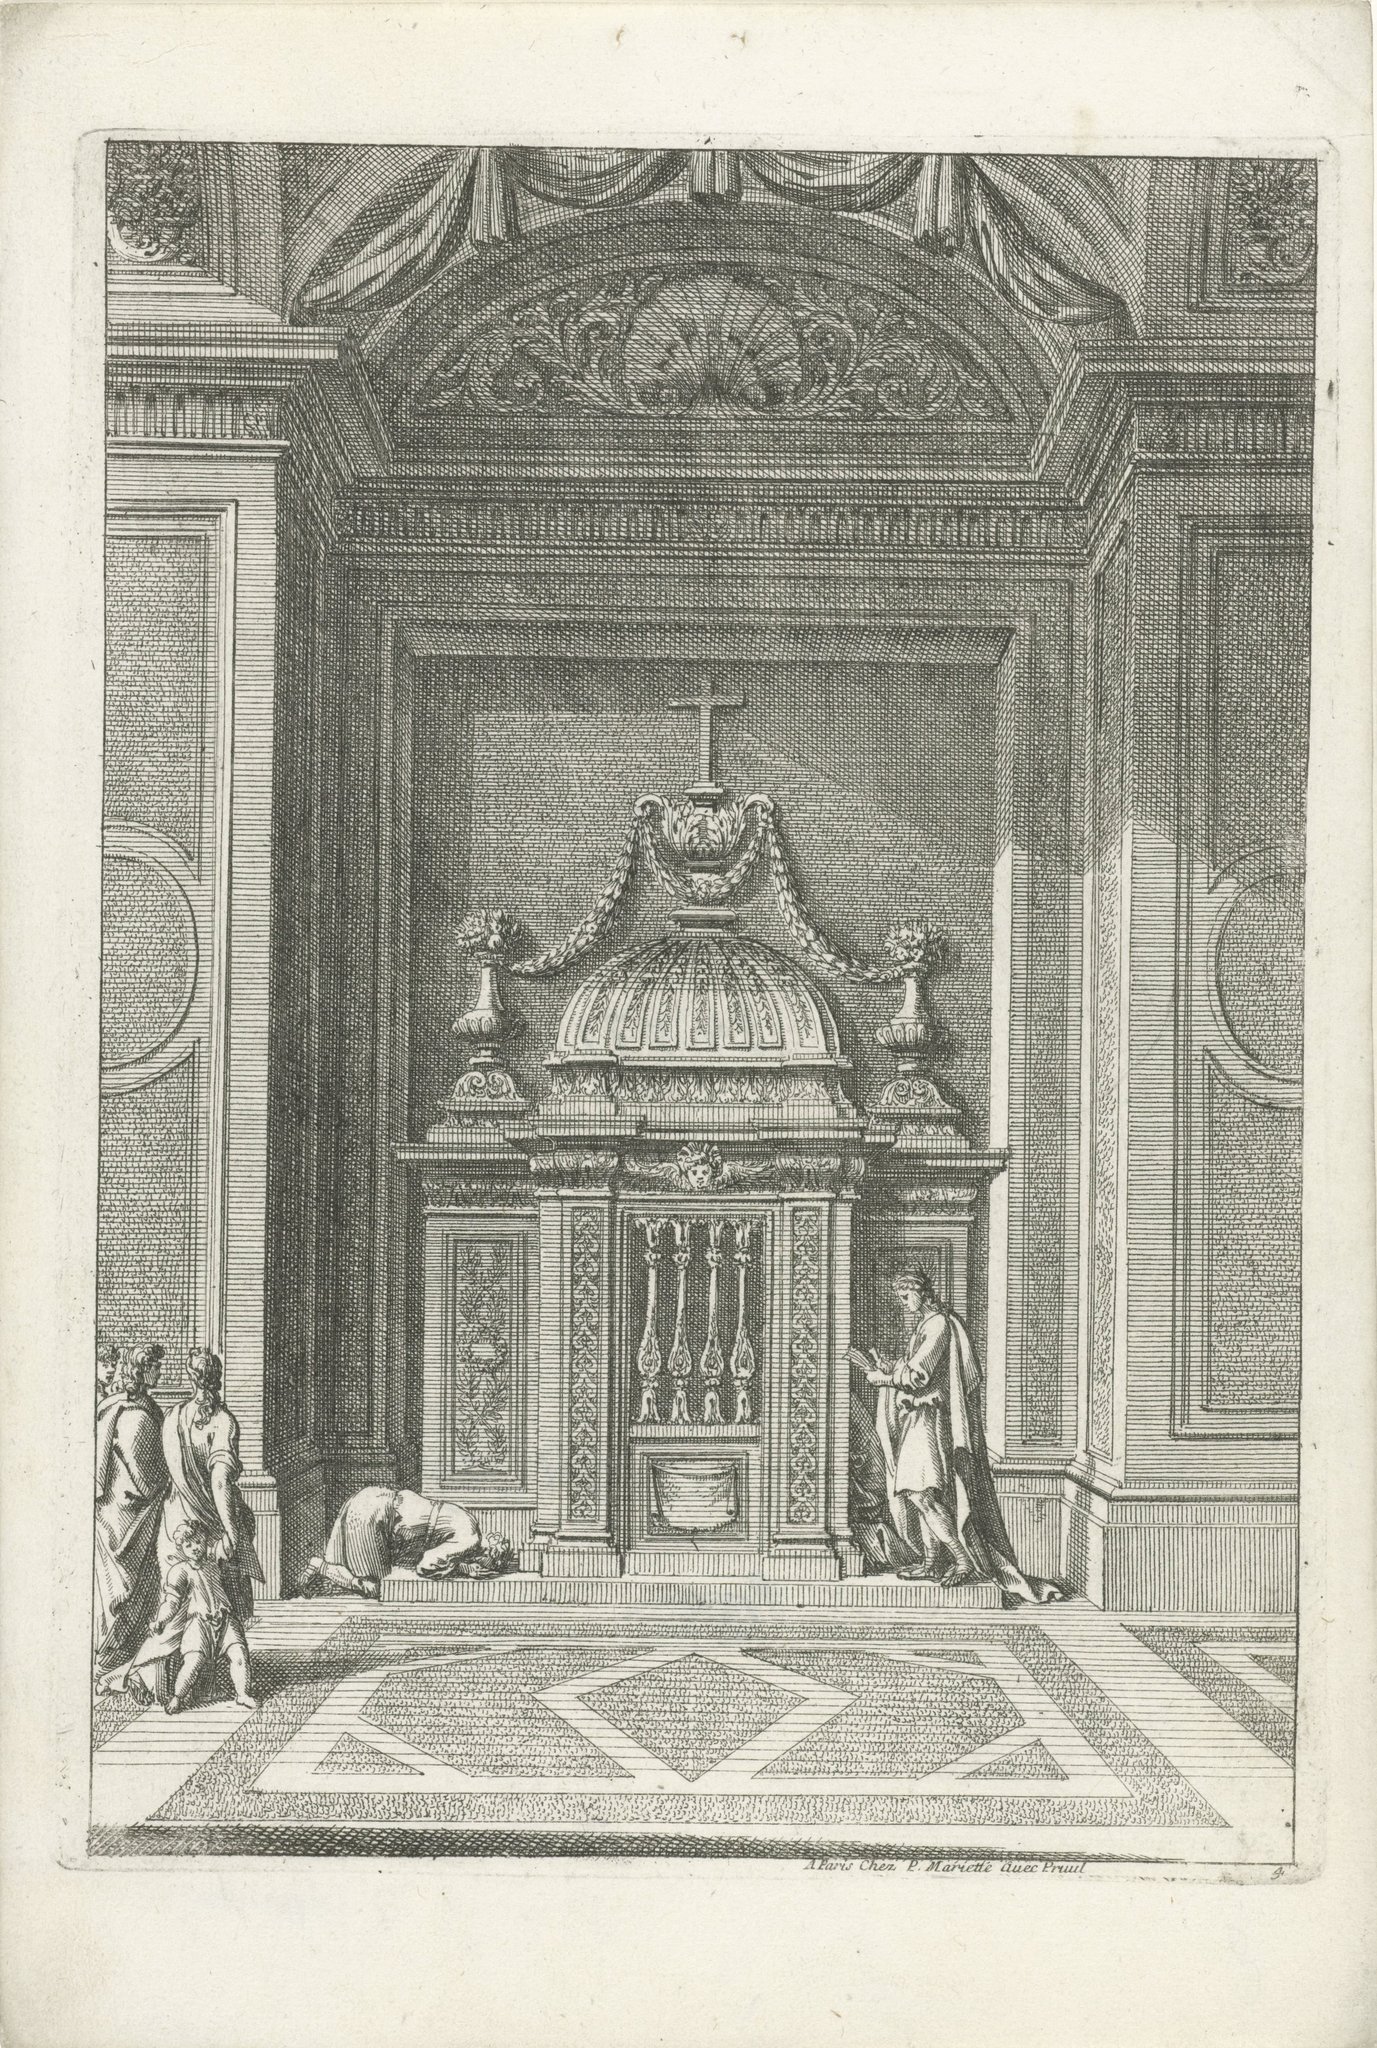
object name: print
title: Biechtstoel in nis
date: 1658-1670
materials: paper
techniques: etching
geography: france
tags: confessional ~ part of the confession